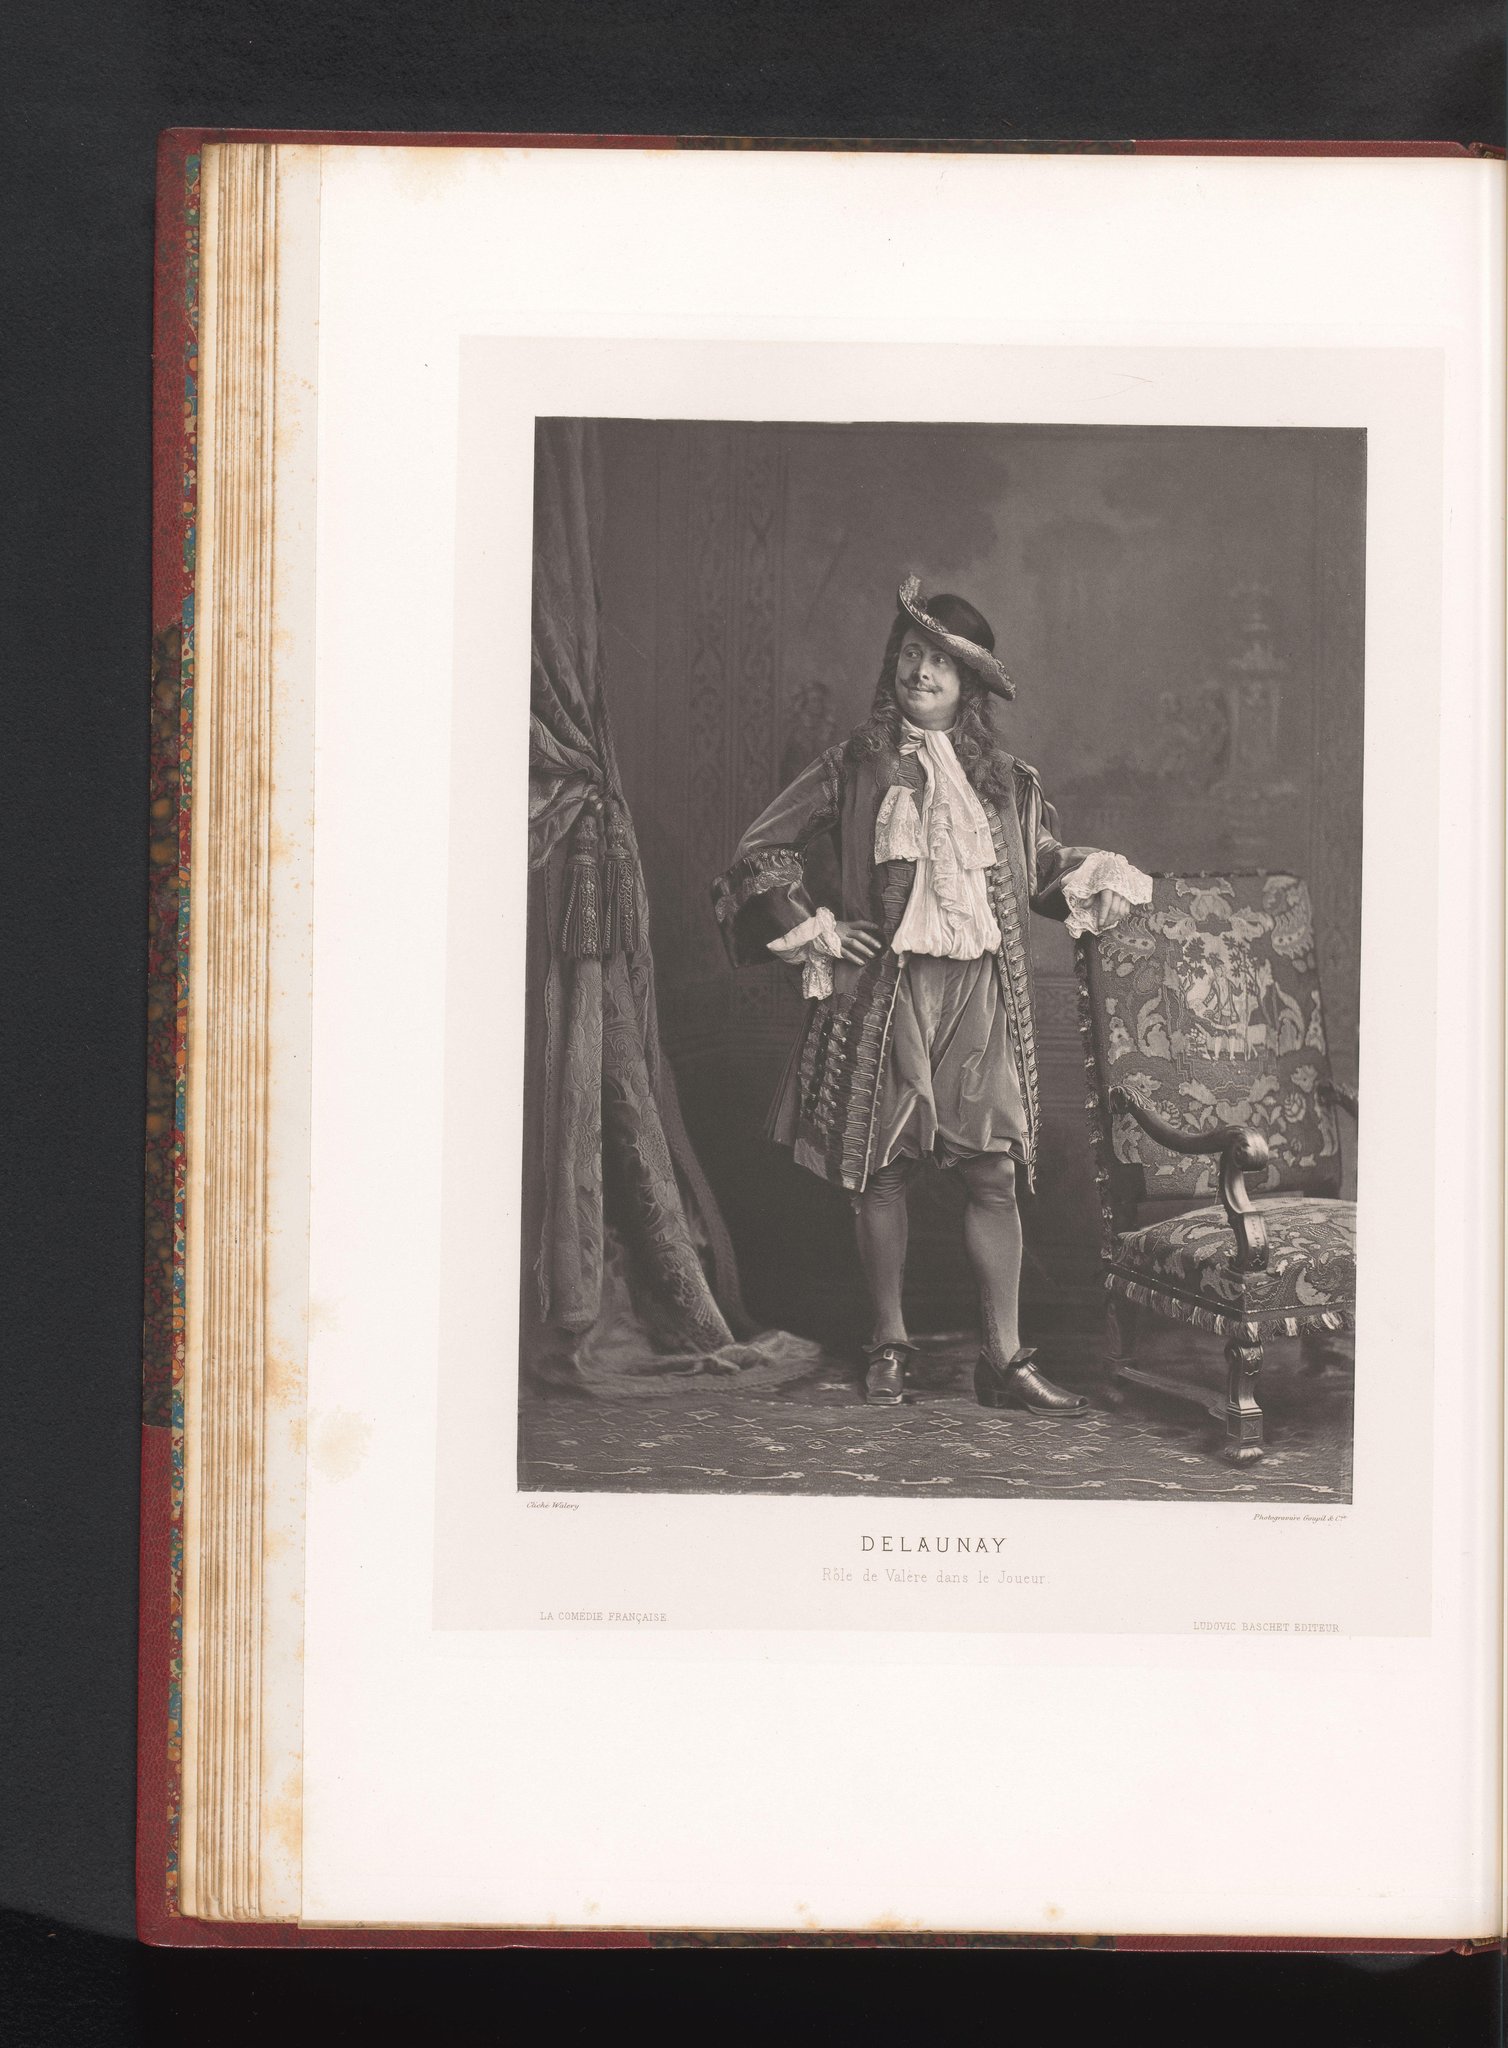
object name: page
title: Portret van Louis Arsène Delaunay in de rol van Valère in Le Joueur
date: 1875-1880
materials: paper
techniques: photoaquatint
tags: louis-arsène delaunay, historical persons, portrait of actor, actress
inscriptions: inscription: ‘LA COMÉDIE FRANÇAISE’